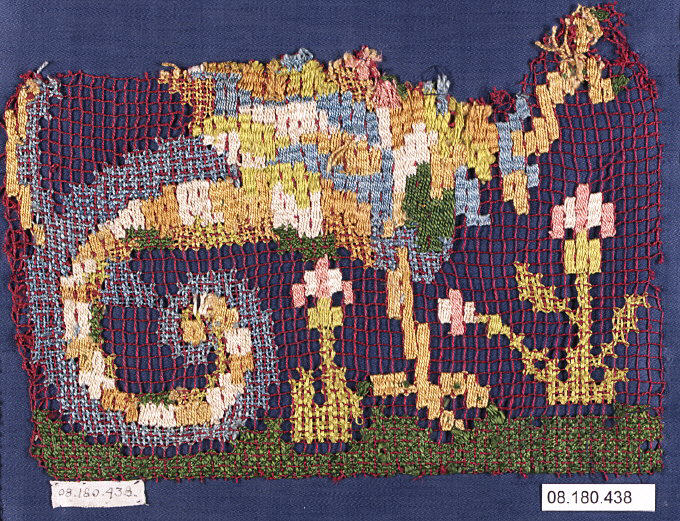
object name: fragment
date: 1601-1700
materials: silk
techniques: embroidery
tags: birds